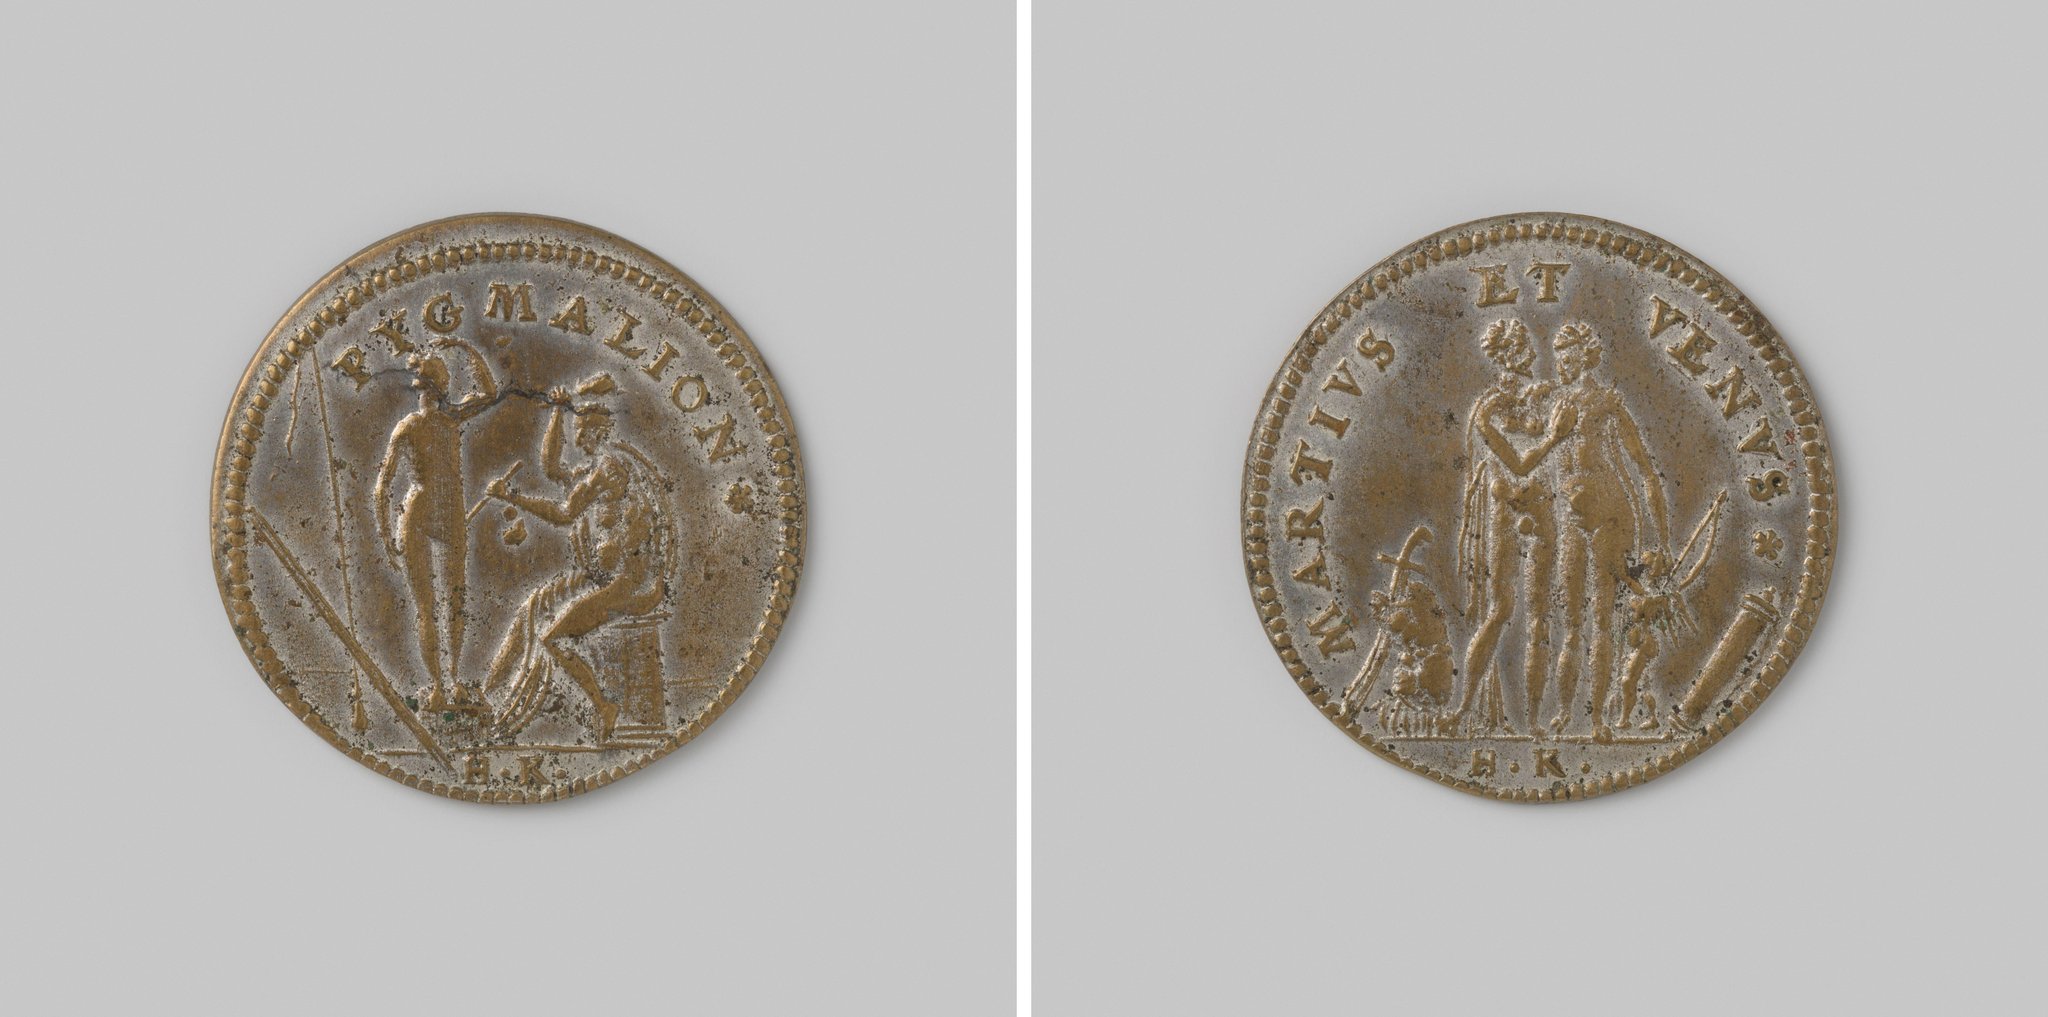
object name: jeton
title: Rekenpenning uit Neurenberg met Pygmalion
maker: hans krauwinckel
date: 1575-1625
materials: brass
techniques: striking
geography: nuremberg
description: Verzilverde messing penning, op de voorzijde Pygmalion die een vrouw beeldhouwt, met bovenaan omschrift, op de keerzijde Mars en Venus met omschrift.